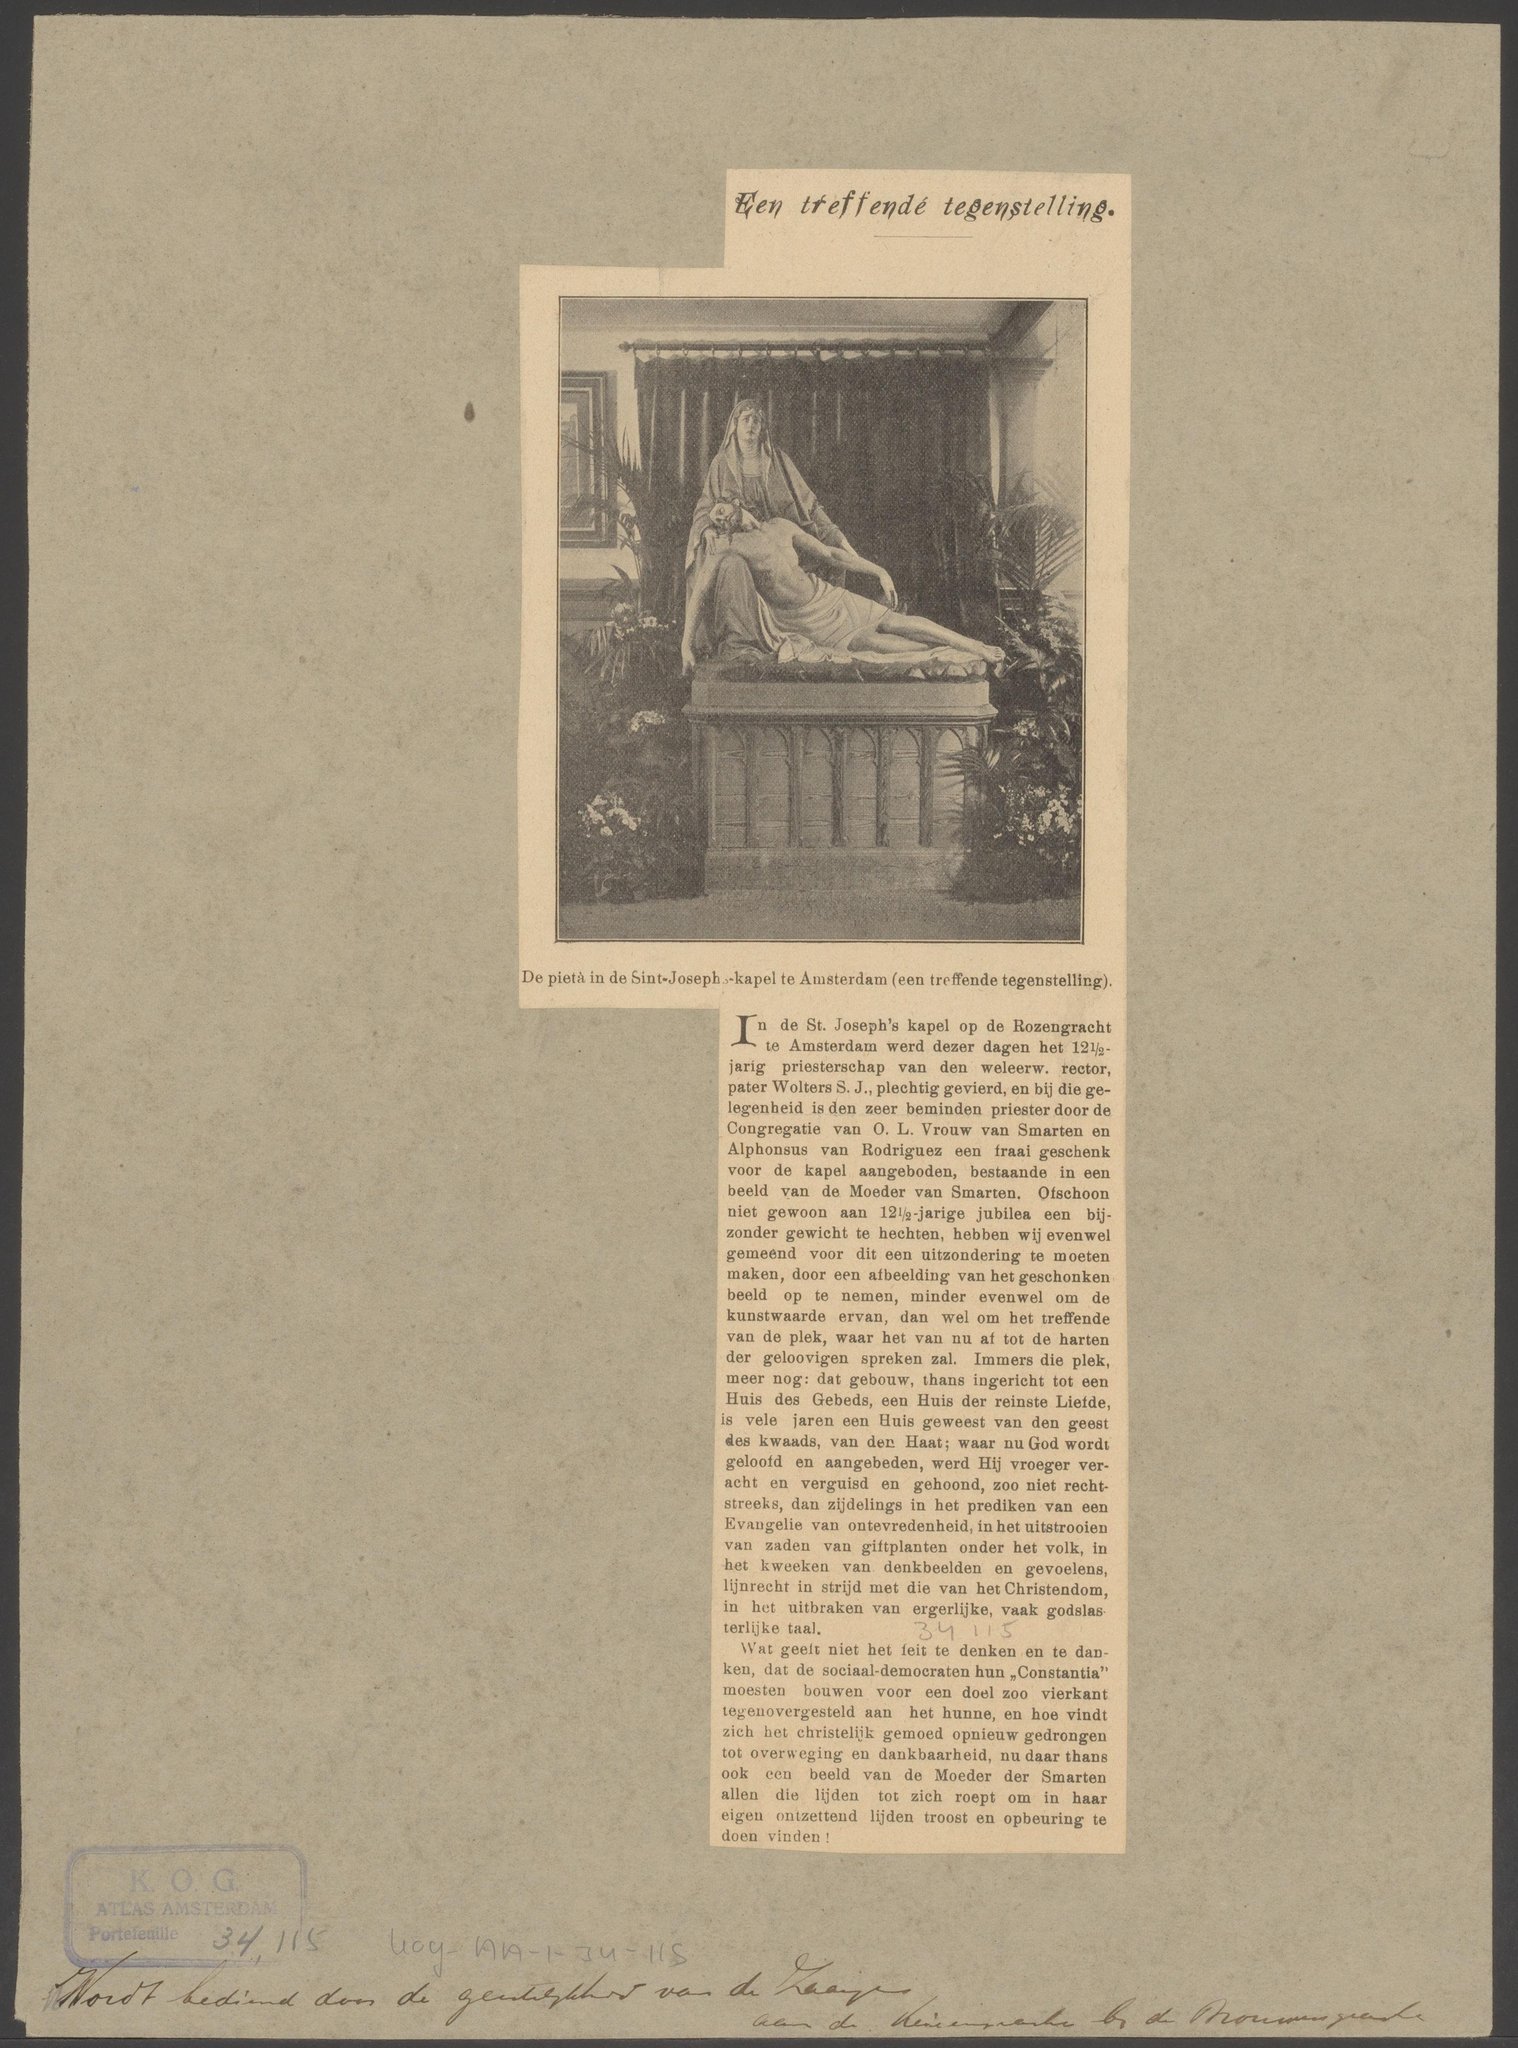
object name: photomechanical print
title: Pietà in de Sint-Jozefskapel te Amsterdam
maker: Anonymous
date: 1899-1928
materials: paper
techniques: letterpress printing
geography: netherlands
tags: 'pietà ', 'vesperbild', 'marienklage' (no others present): christ, either with or without crown of thorns, mourned by mary, monument, statue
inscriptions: collector's mark: Lugt 1641b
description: Onderwerpsrubriek binnen de Atlas Amsterdam: Kerkwezen: R.K. Gemeenten: Begijnhof t/m Petrus en Paulus.